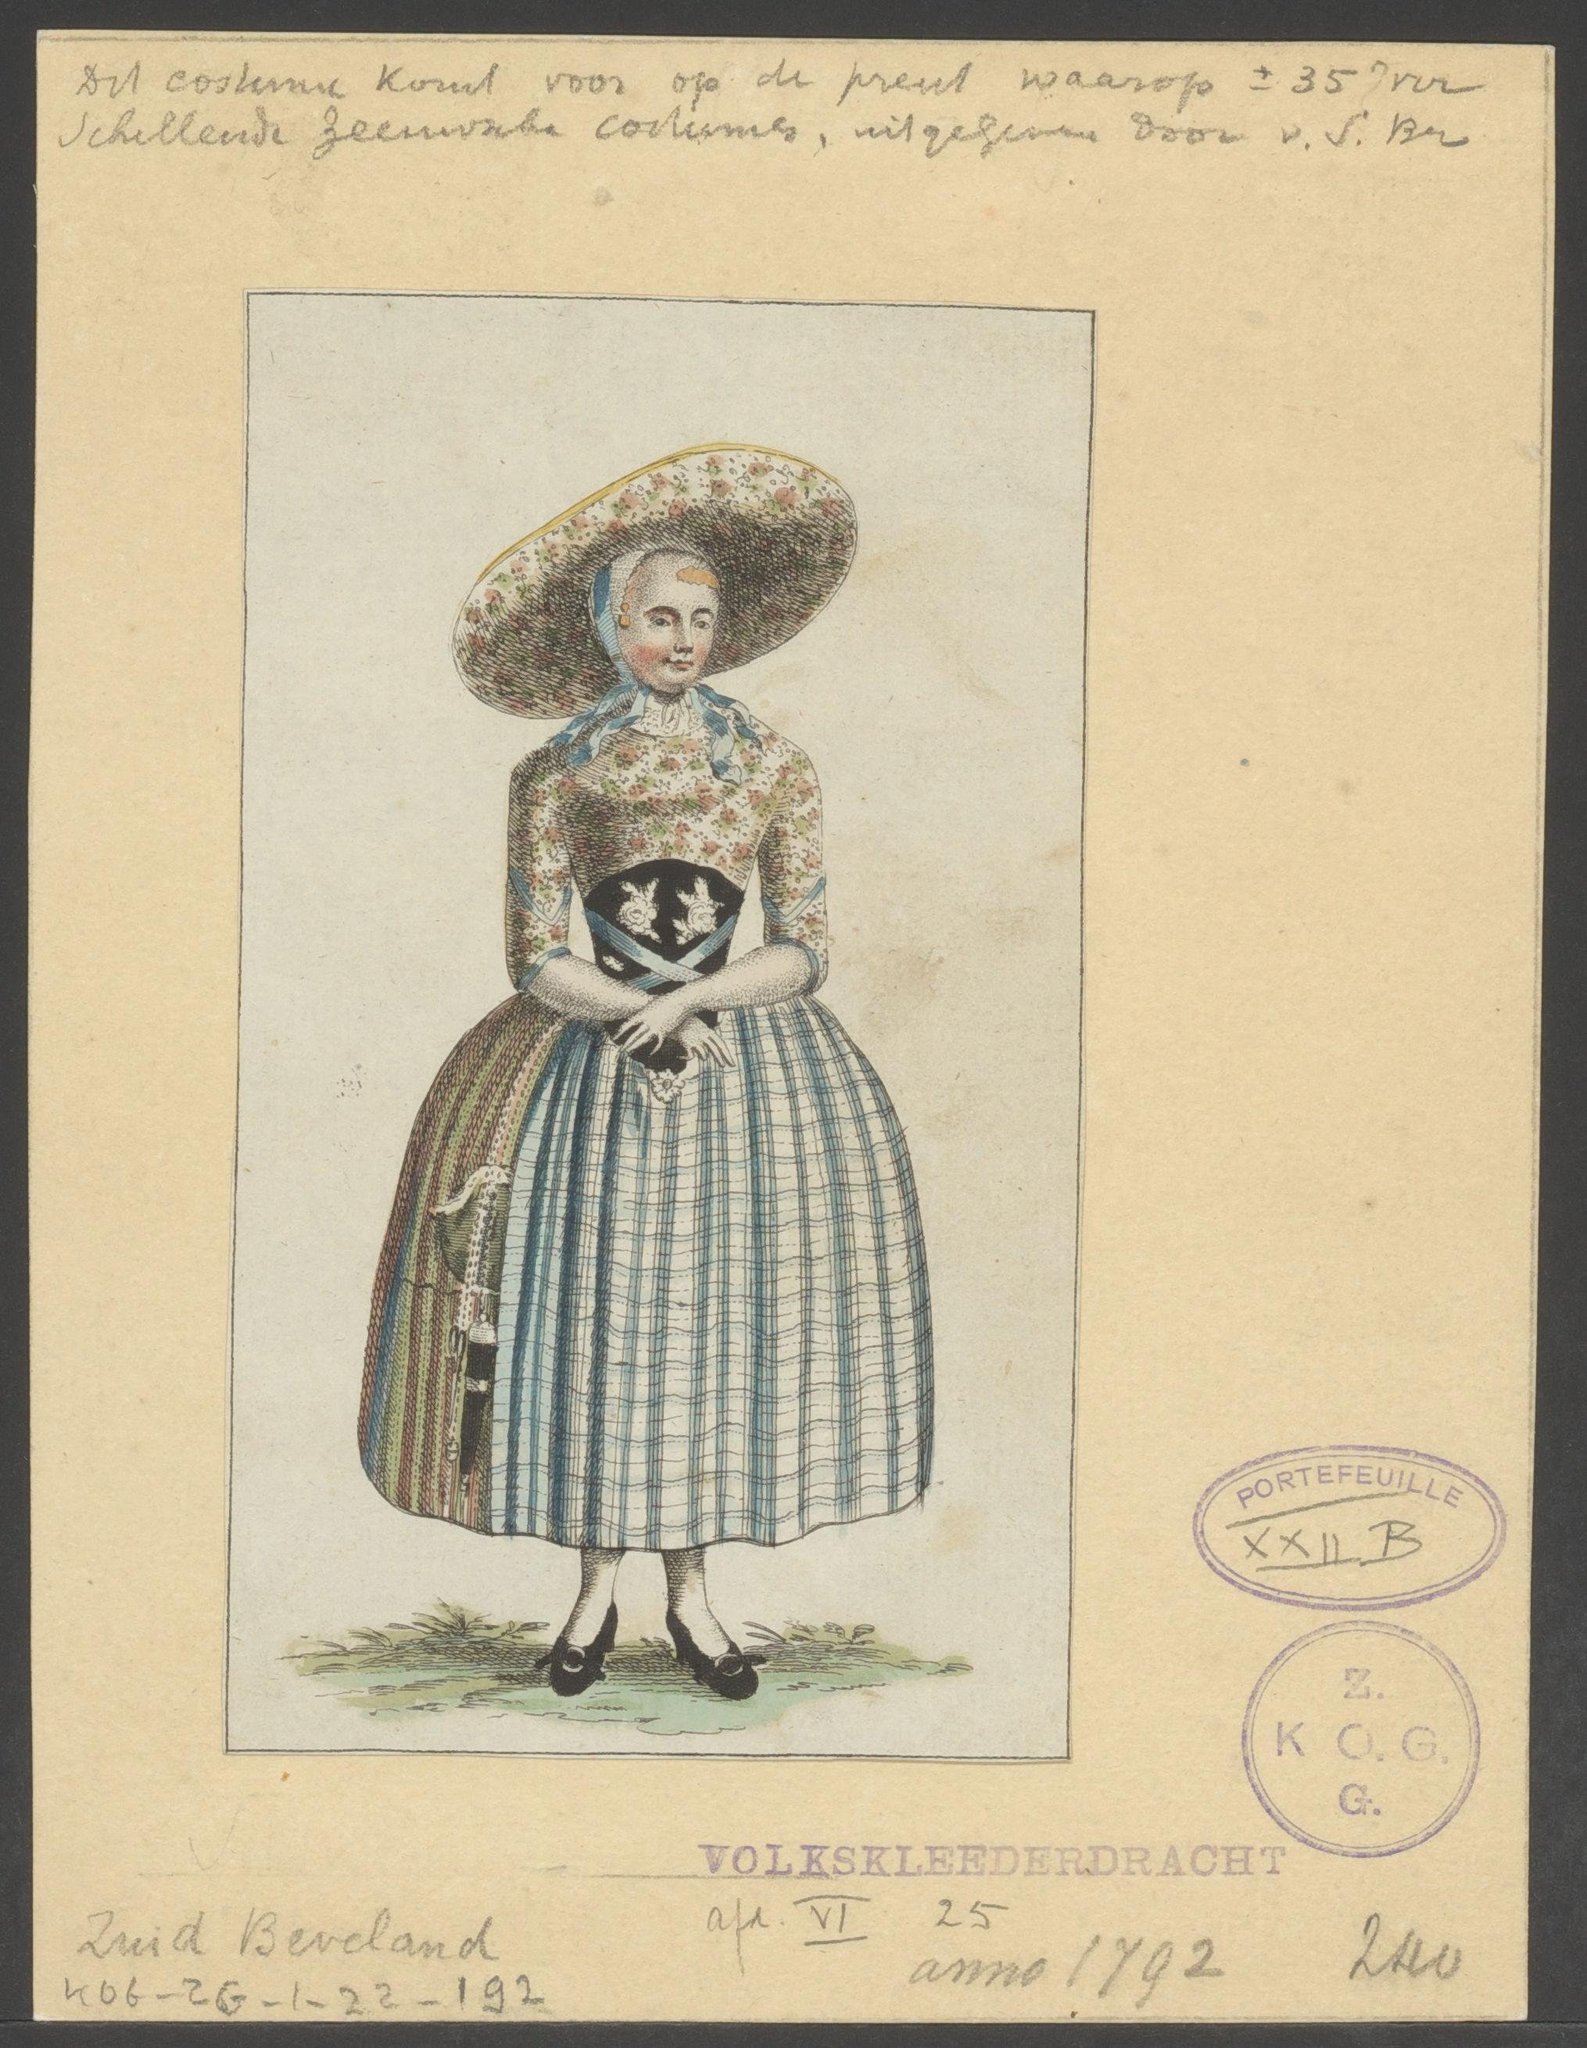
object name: book illustration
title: Vrouw van Zuid-Beveland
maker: Anonymous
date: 1792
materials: paper, watercolor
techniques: etching, hand coloring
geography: netherlands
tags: clothes, costume (+ women's clothes), folk costume, regional costume, zeeland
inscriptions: collector's mark, collector's mark: Lugt 1641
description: Vrouw in de klederdracht van Zuid-Beveland, staande met de handen gekruist voor de buik. Onderwerpsrubrieken binnen de Atlas Zeden en Gewoonten: De Kleeding, Volkskleederdracht, Zeeland.